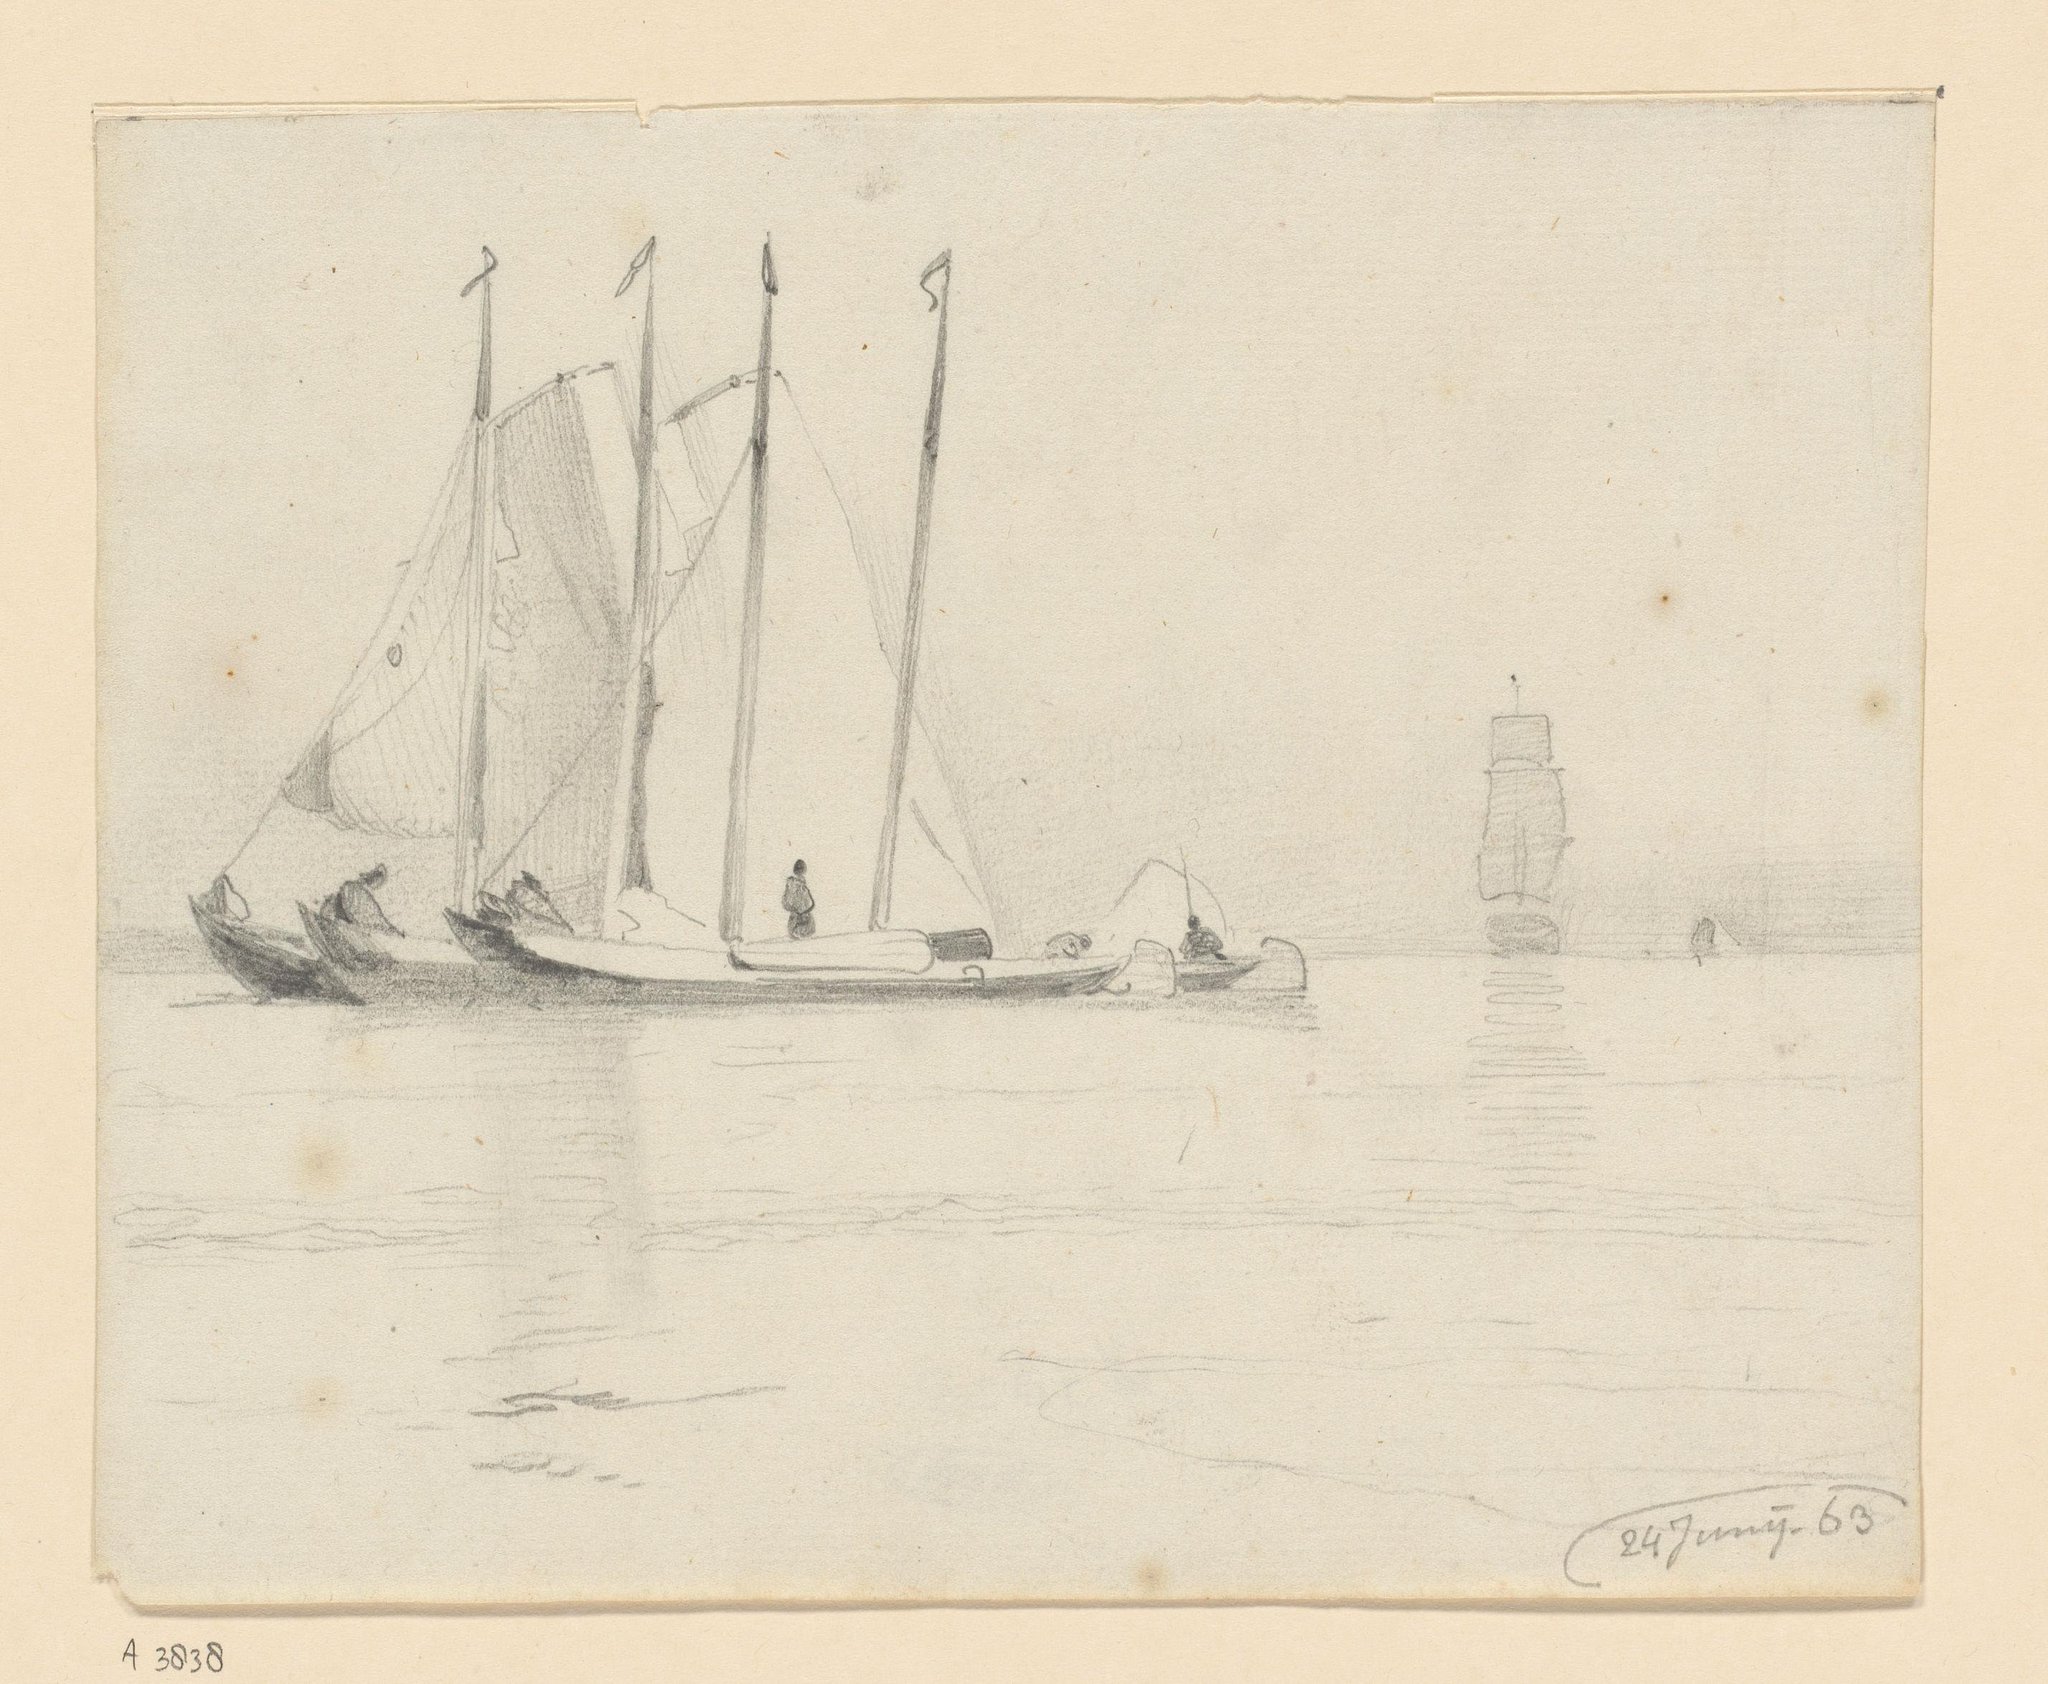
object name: drawing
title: Drie schuiten naast elkaar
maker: willem anthonie van deventer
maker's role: draughtsman, painter, print maker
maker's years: 1824-1893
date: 1863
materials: paper, pencil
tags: sailing-ship, sailing-boat